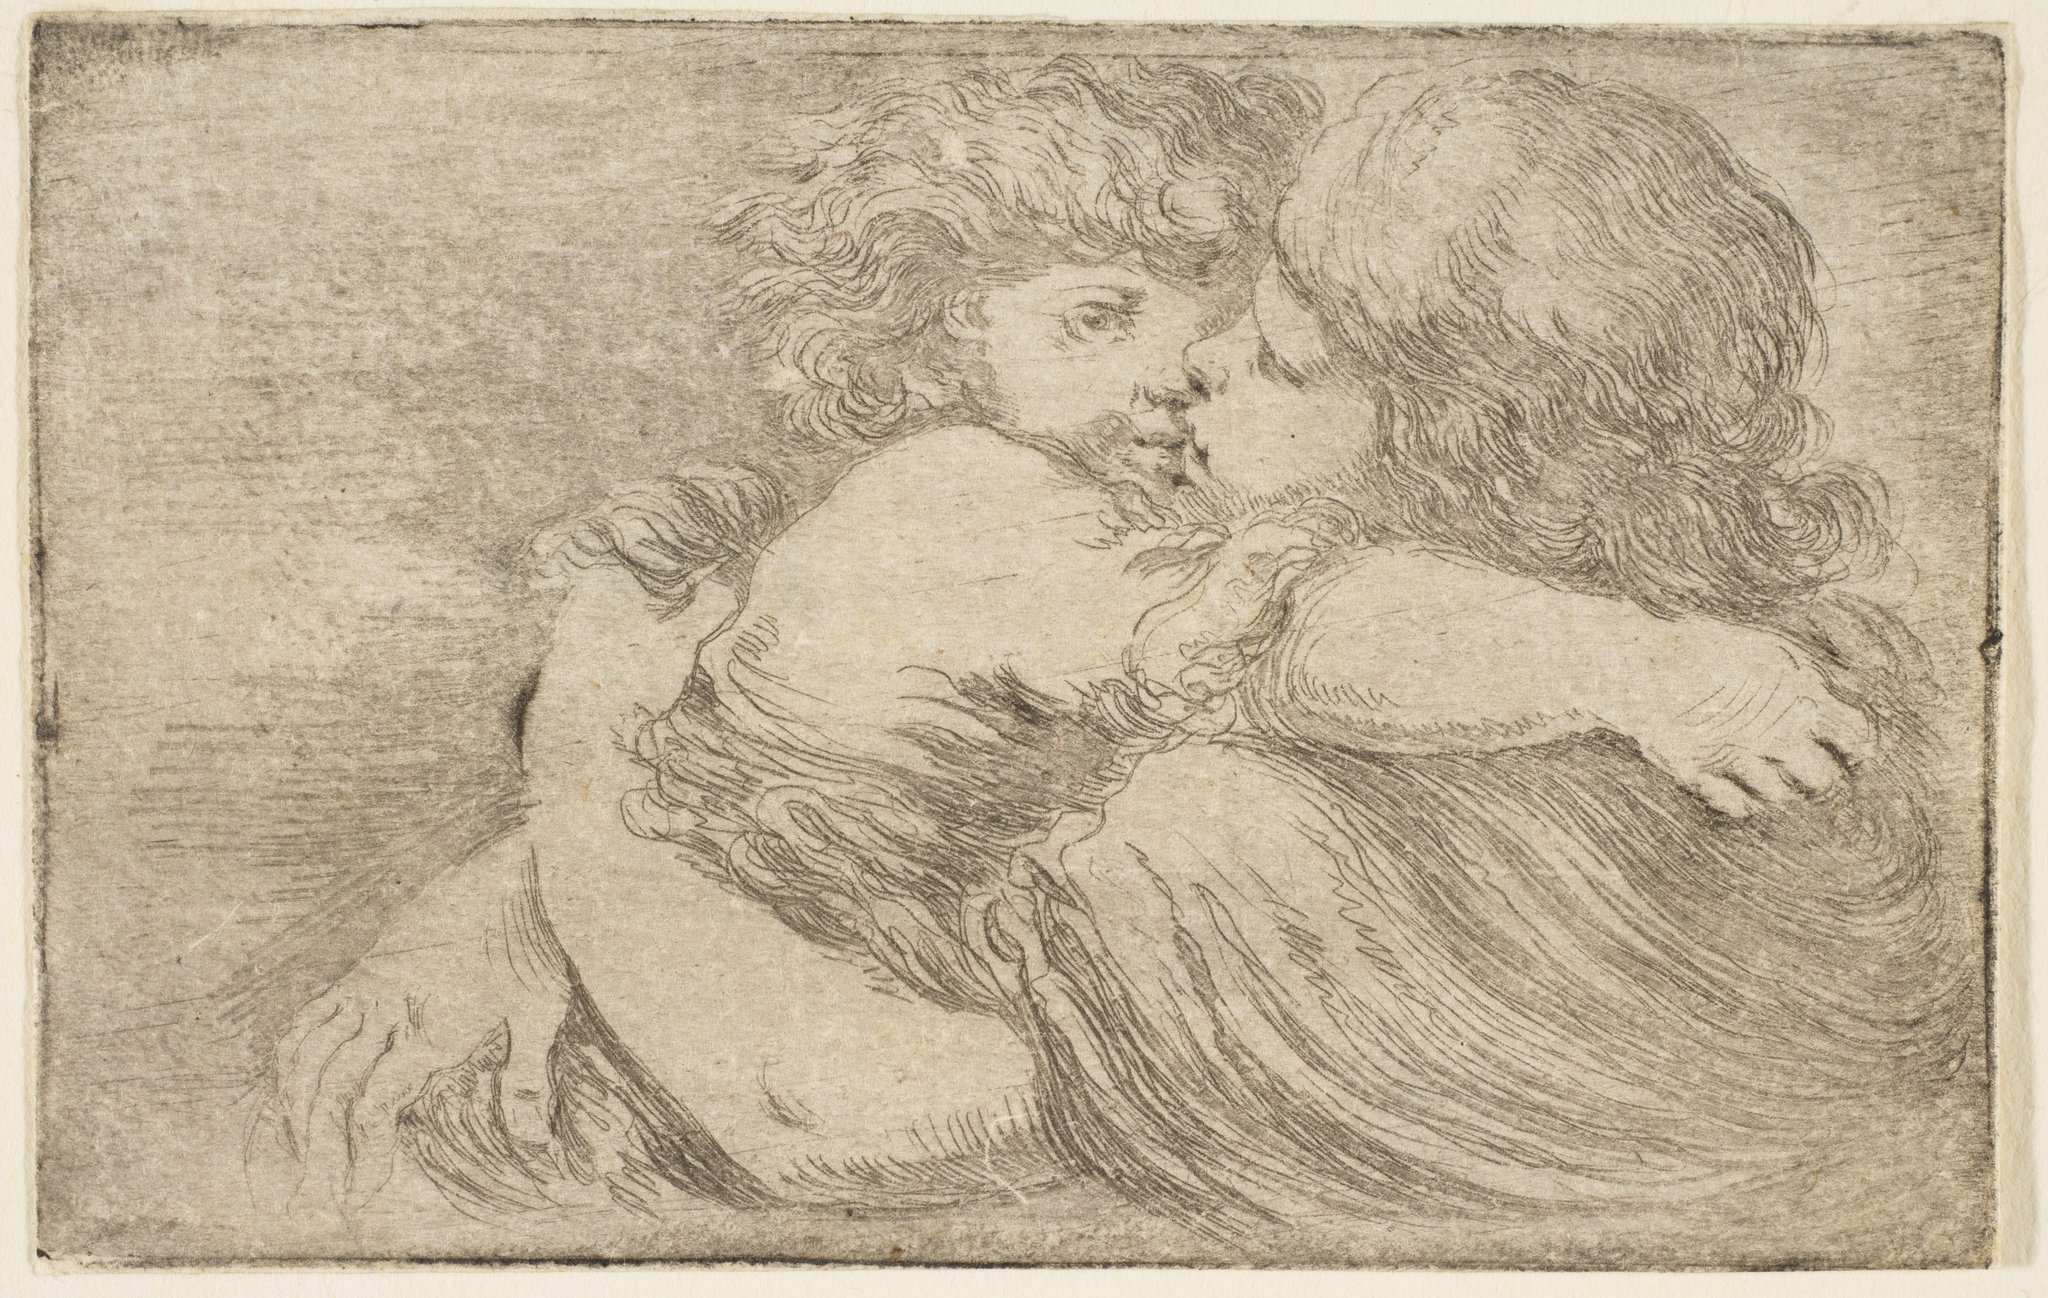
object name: print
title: Two Children Embrace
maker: stefano della bella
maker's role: artist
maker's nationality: italian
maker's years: 1610-1664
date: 1662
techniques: etching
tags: children